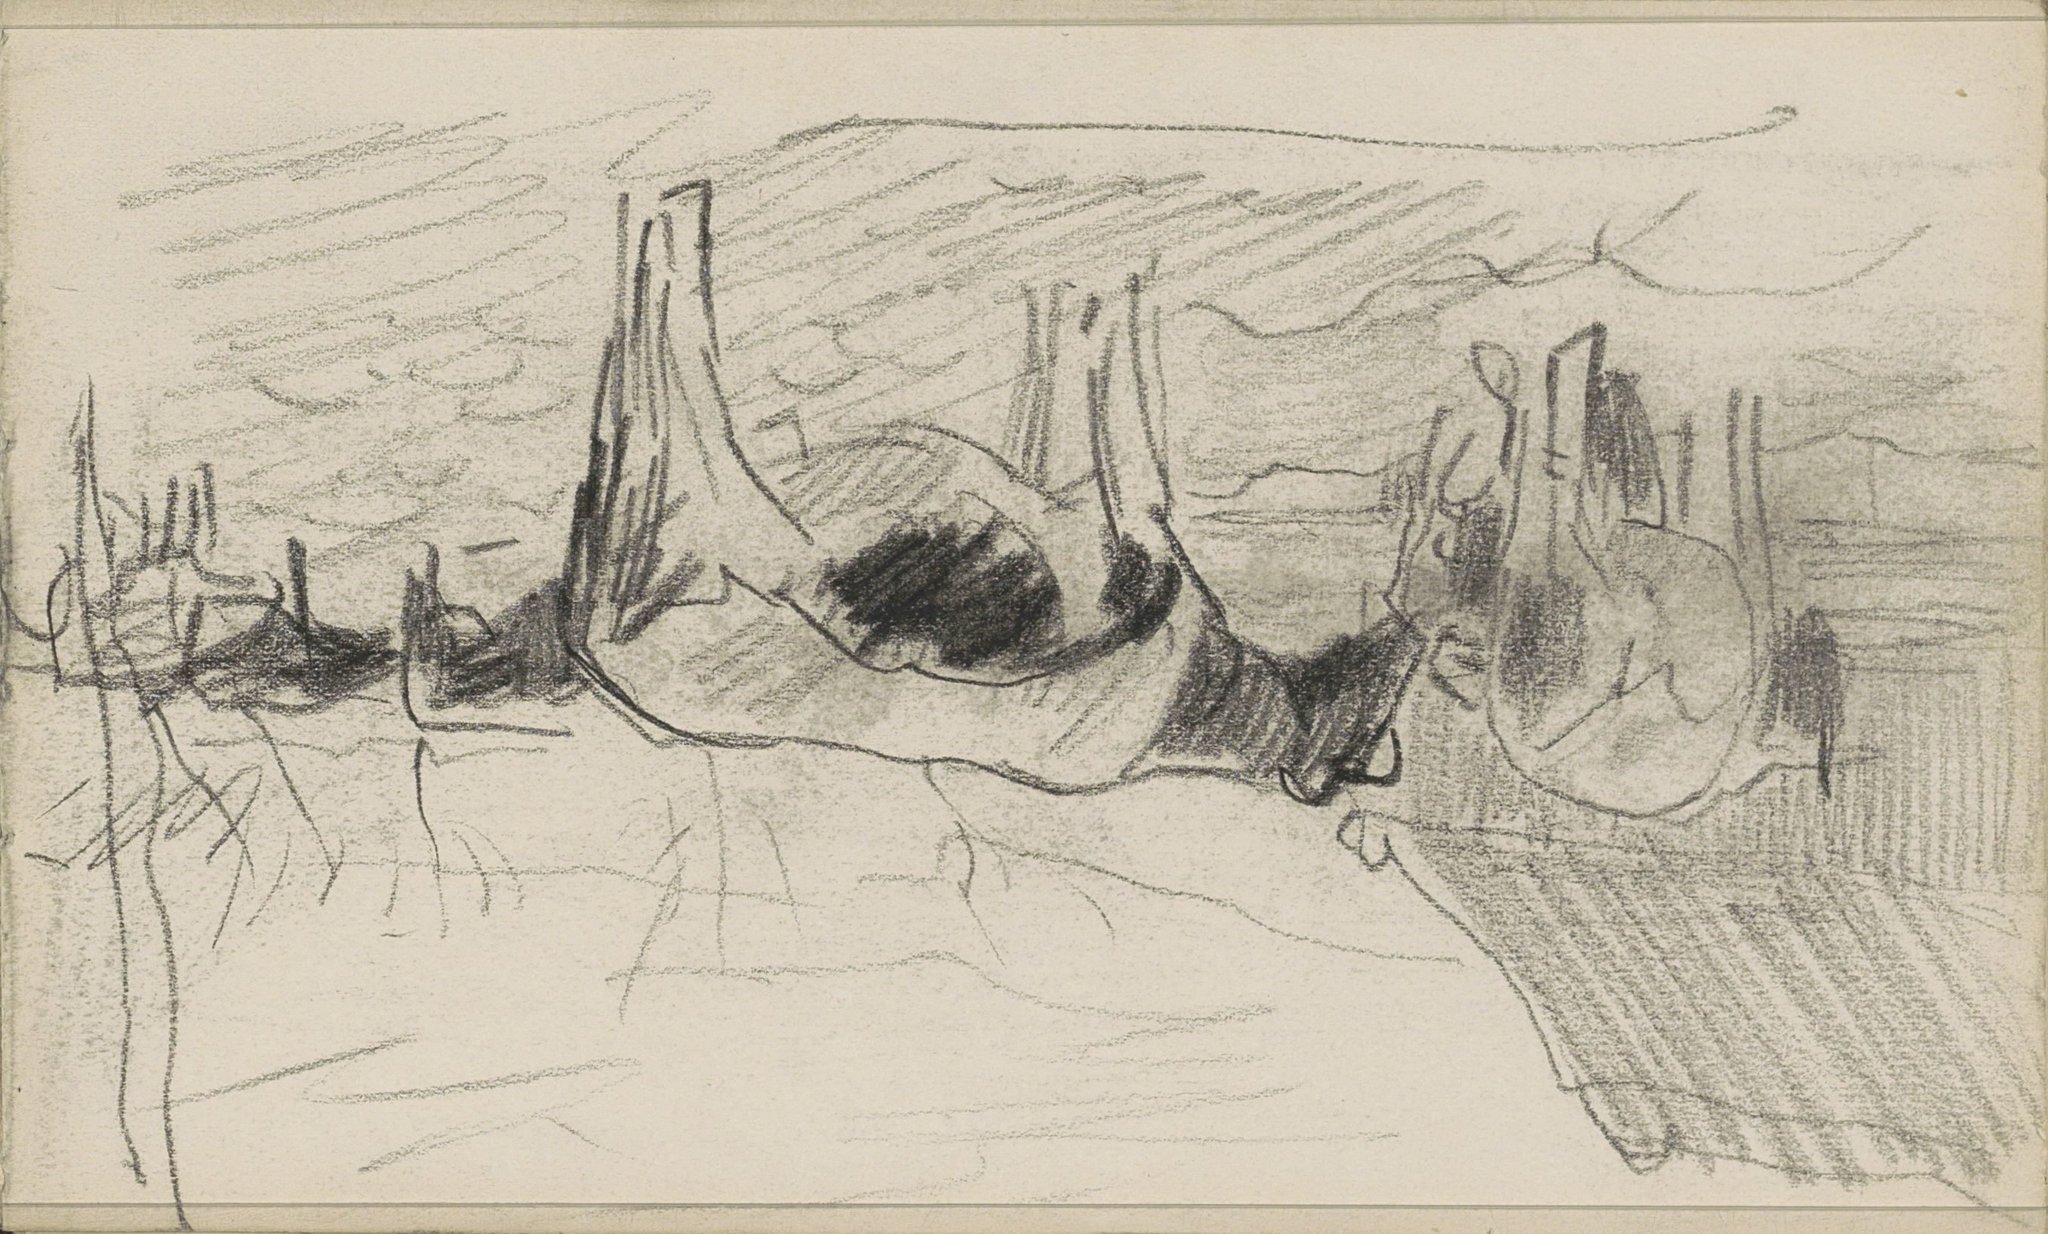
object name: sketchbook leaf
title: Koeien in een weiland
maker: anton mauve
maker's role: draughtsman, painter, print maker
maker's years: 1838-1888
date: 1848-1888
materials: chalk, paper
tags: cow, meadow, pasture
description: Blad 8 recto uit een schetsboek met 33 bladen.